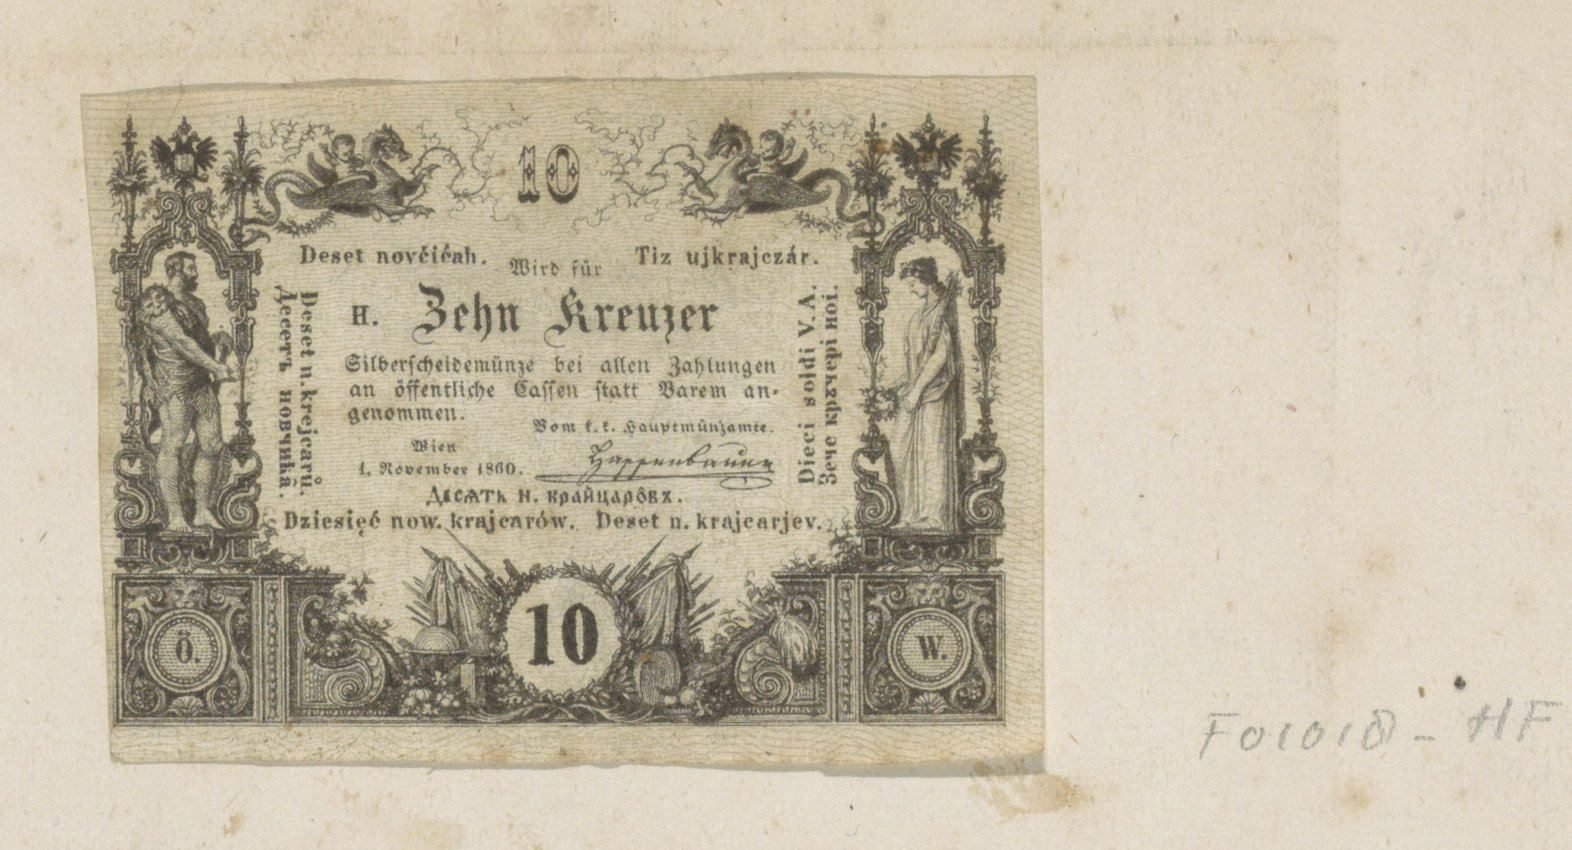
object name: bank note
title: Eenzijdig bankbiljet van 10 Kreuzer van het keizerrijk Oostenrijk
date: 1860-1870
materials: paper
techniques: printing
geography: austria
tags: bank-note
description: Voorzijde: meertalig opschrift, waardeaanduiding, uitgiftedatum en signatuur tussen twee figuren op sokkels. Keerzijde: blanco.